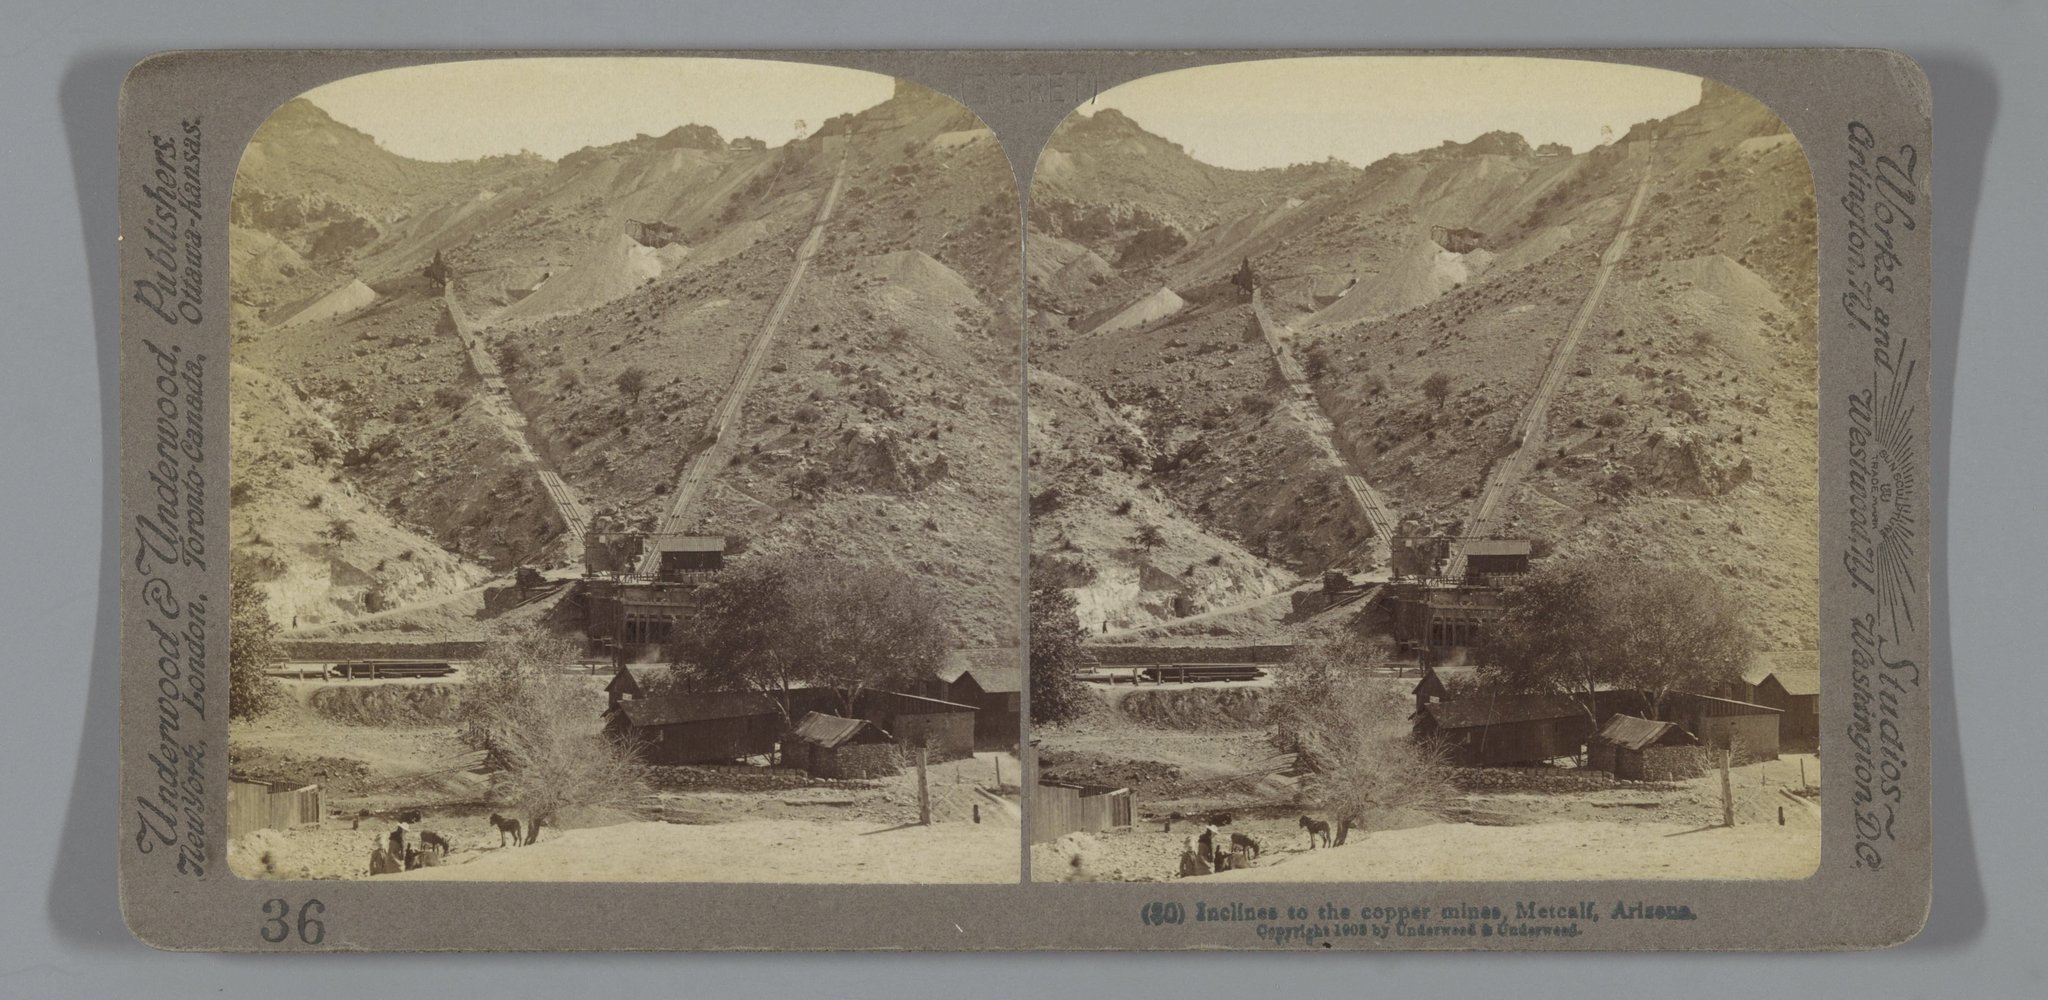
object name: stereograph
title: Inclines to the copper mines, Metcalf, Arizona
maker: Anonymous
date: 1903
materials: cardboard, paper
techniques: albumen print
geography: new york city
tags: mining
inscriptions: title: ‘Inclines to the Copper Mines, Metcalf, Arizona.’, inscription: ‘F 13’, number: ‘36’, number: ‘30’, inscription: ‘In order ro reach this place you have to ride/ seven miles from (...)’, copyright notice: ‘Copyright 1903 by Underwood & Underwood.’, check stamp: ‘(ENERET)’, inscription: ‘SUN SCULPTURE/ UU/ TRADEMARK/ Works and Studios/ Arlington, N.J. Westwood, N.J. Washington, D.C.’